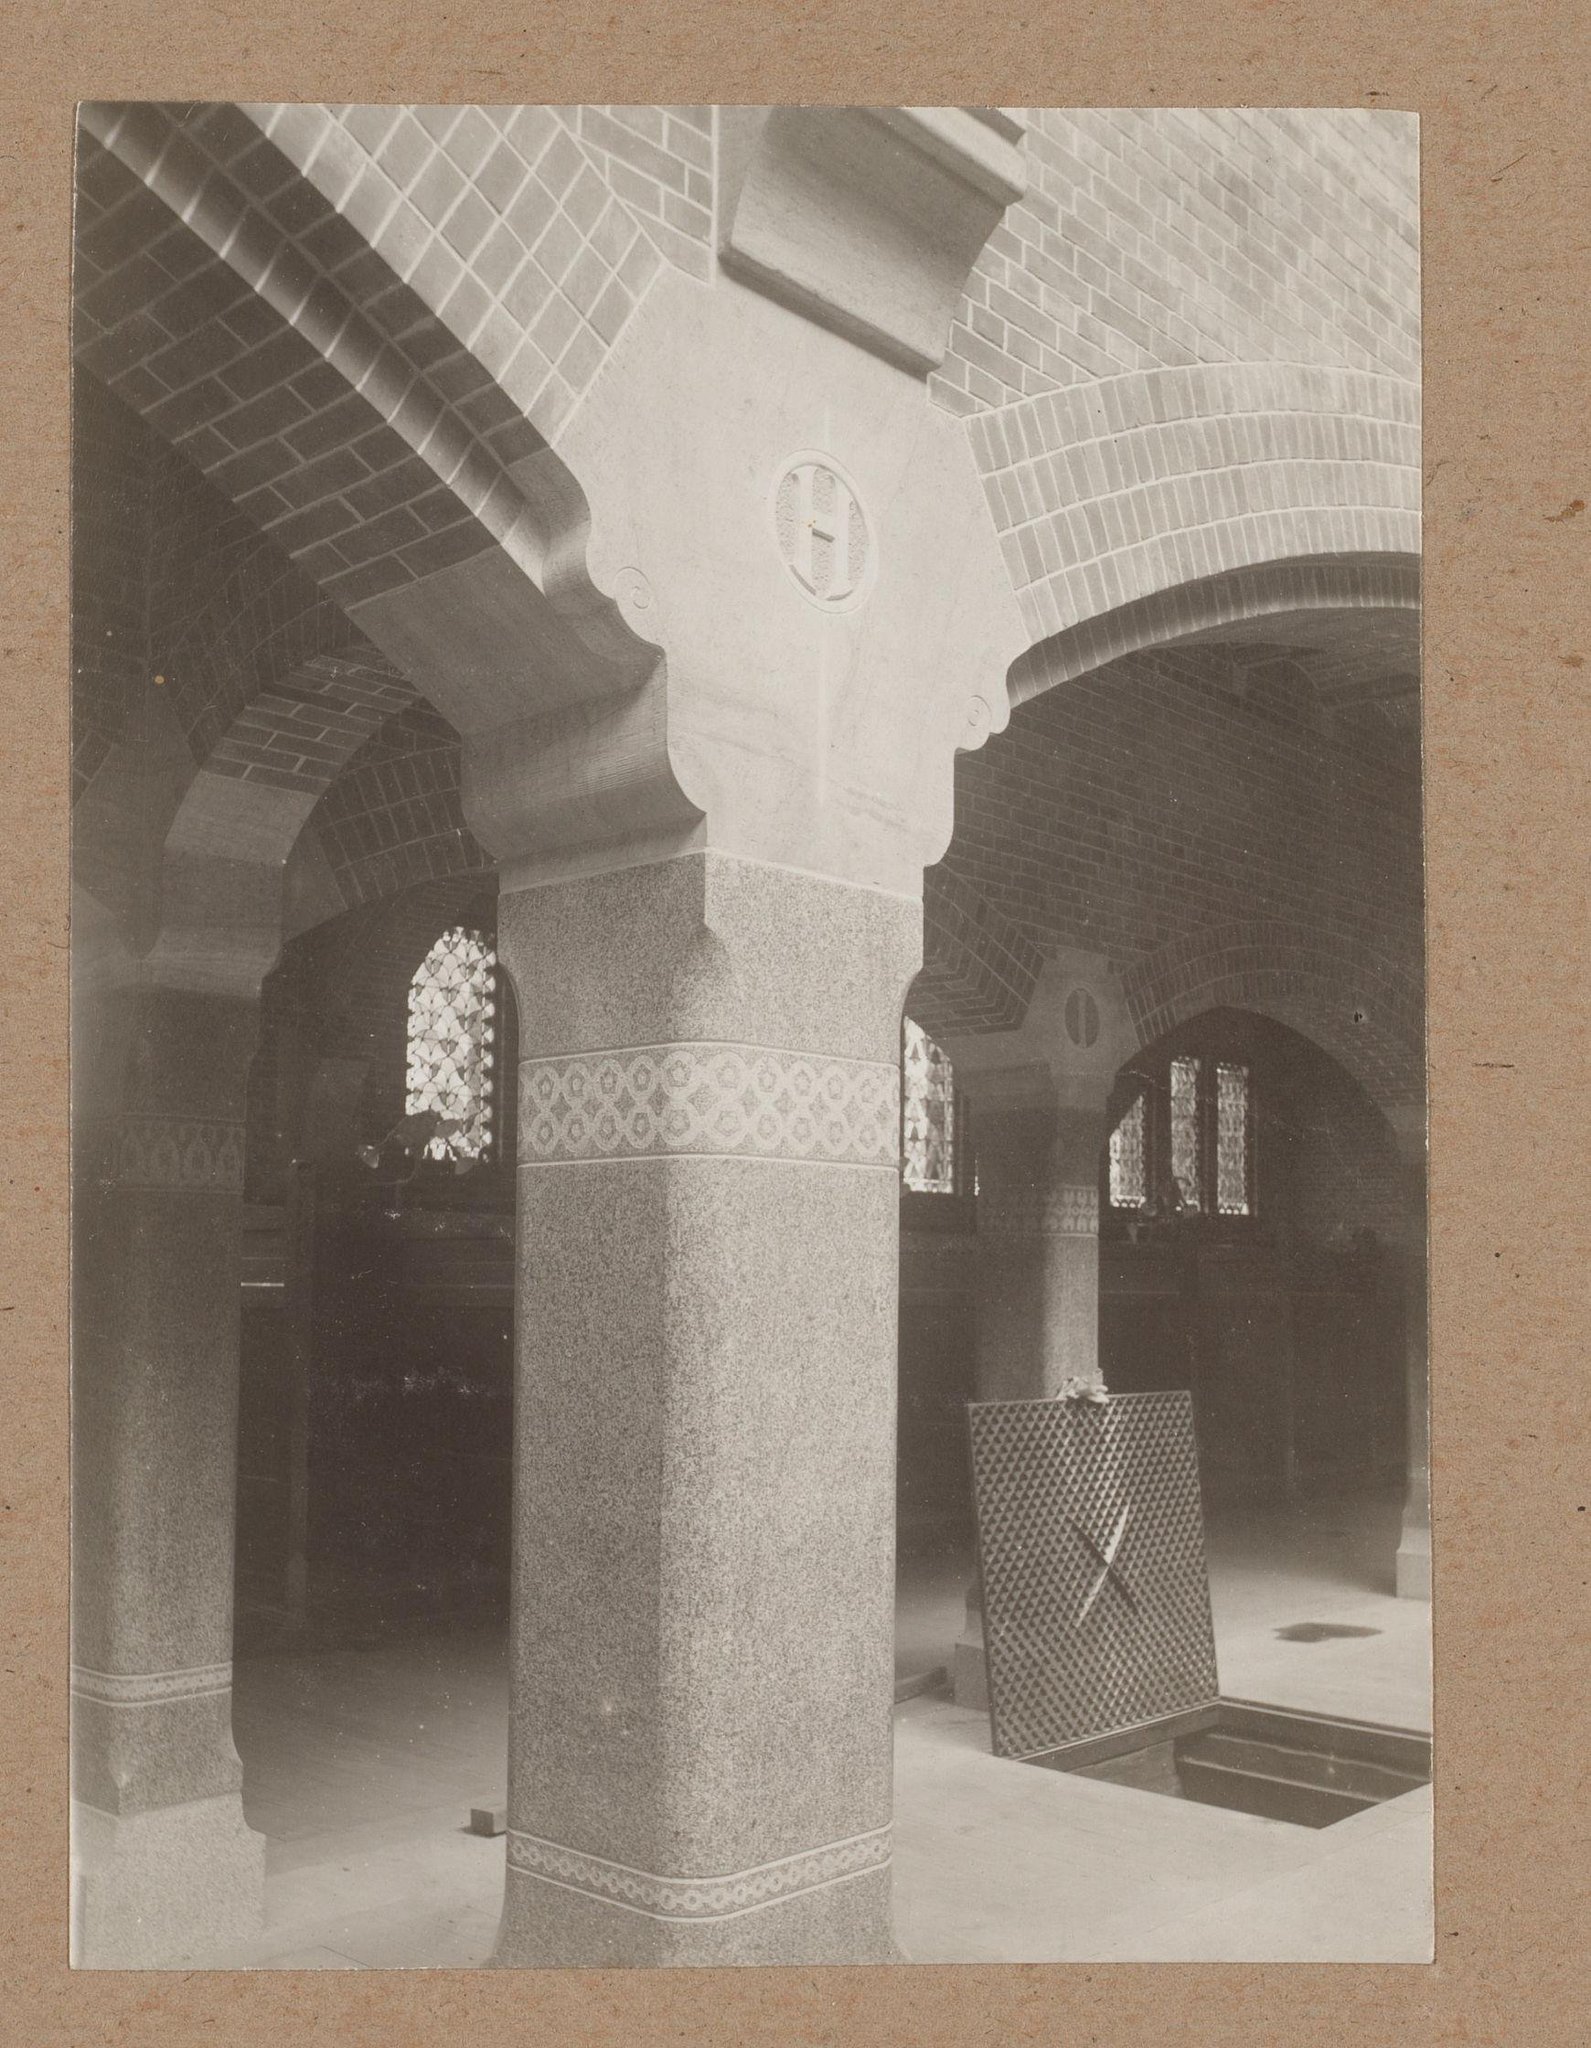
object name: photograph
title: Zuil in de Goederenbeurszaal van de Beurs van Berlage te Amsterdam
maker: Anonymous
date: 1903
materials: paper, cardboard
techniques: gelatin silver print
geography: amsterdam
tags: column, pillar ~ architecture, stock exchange, stock-market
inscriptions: number: ‘9 a b’